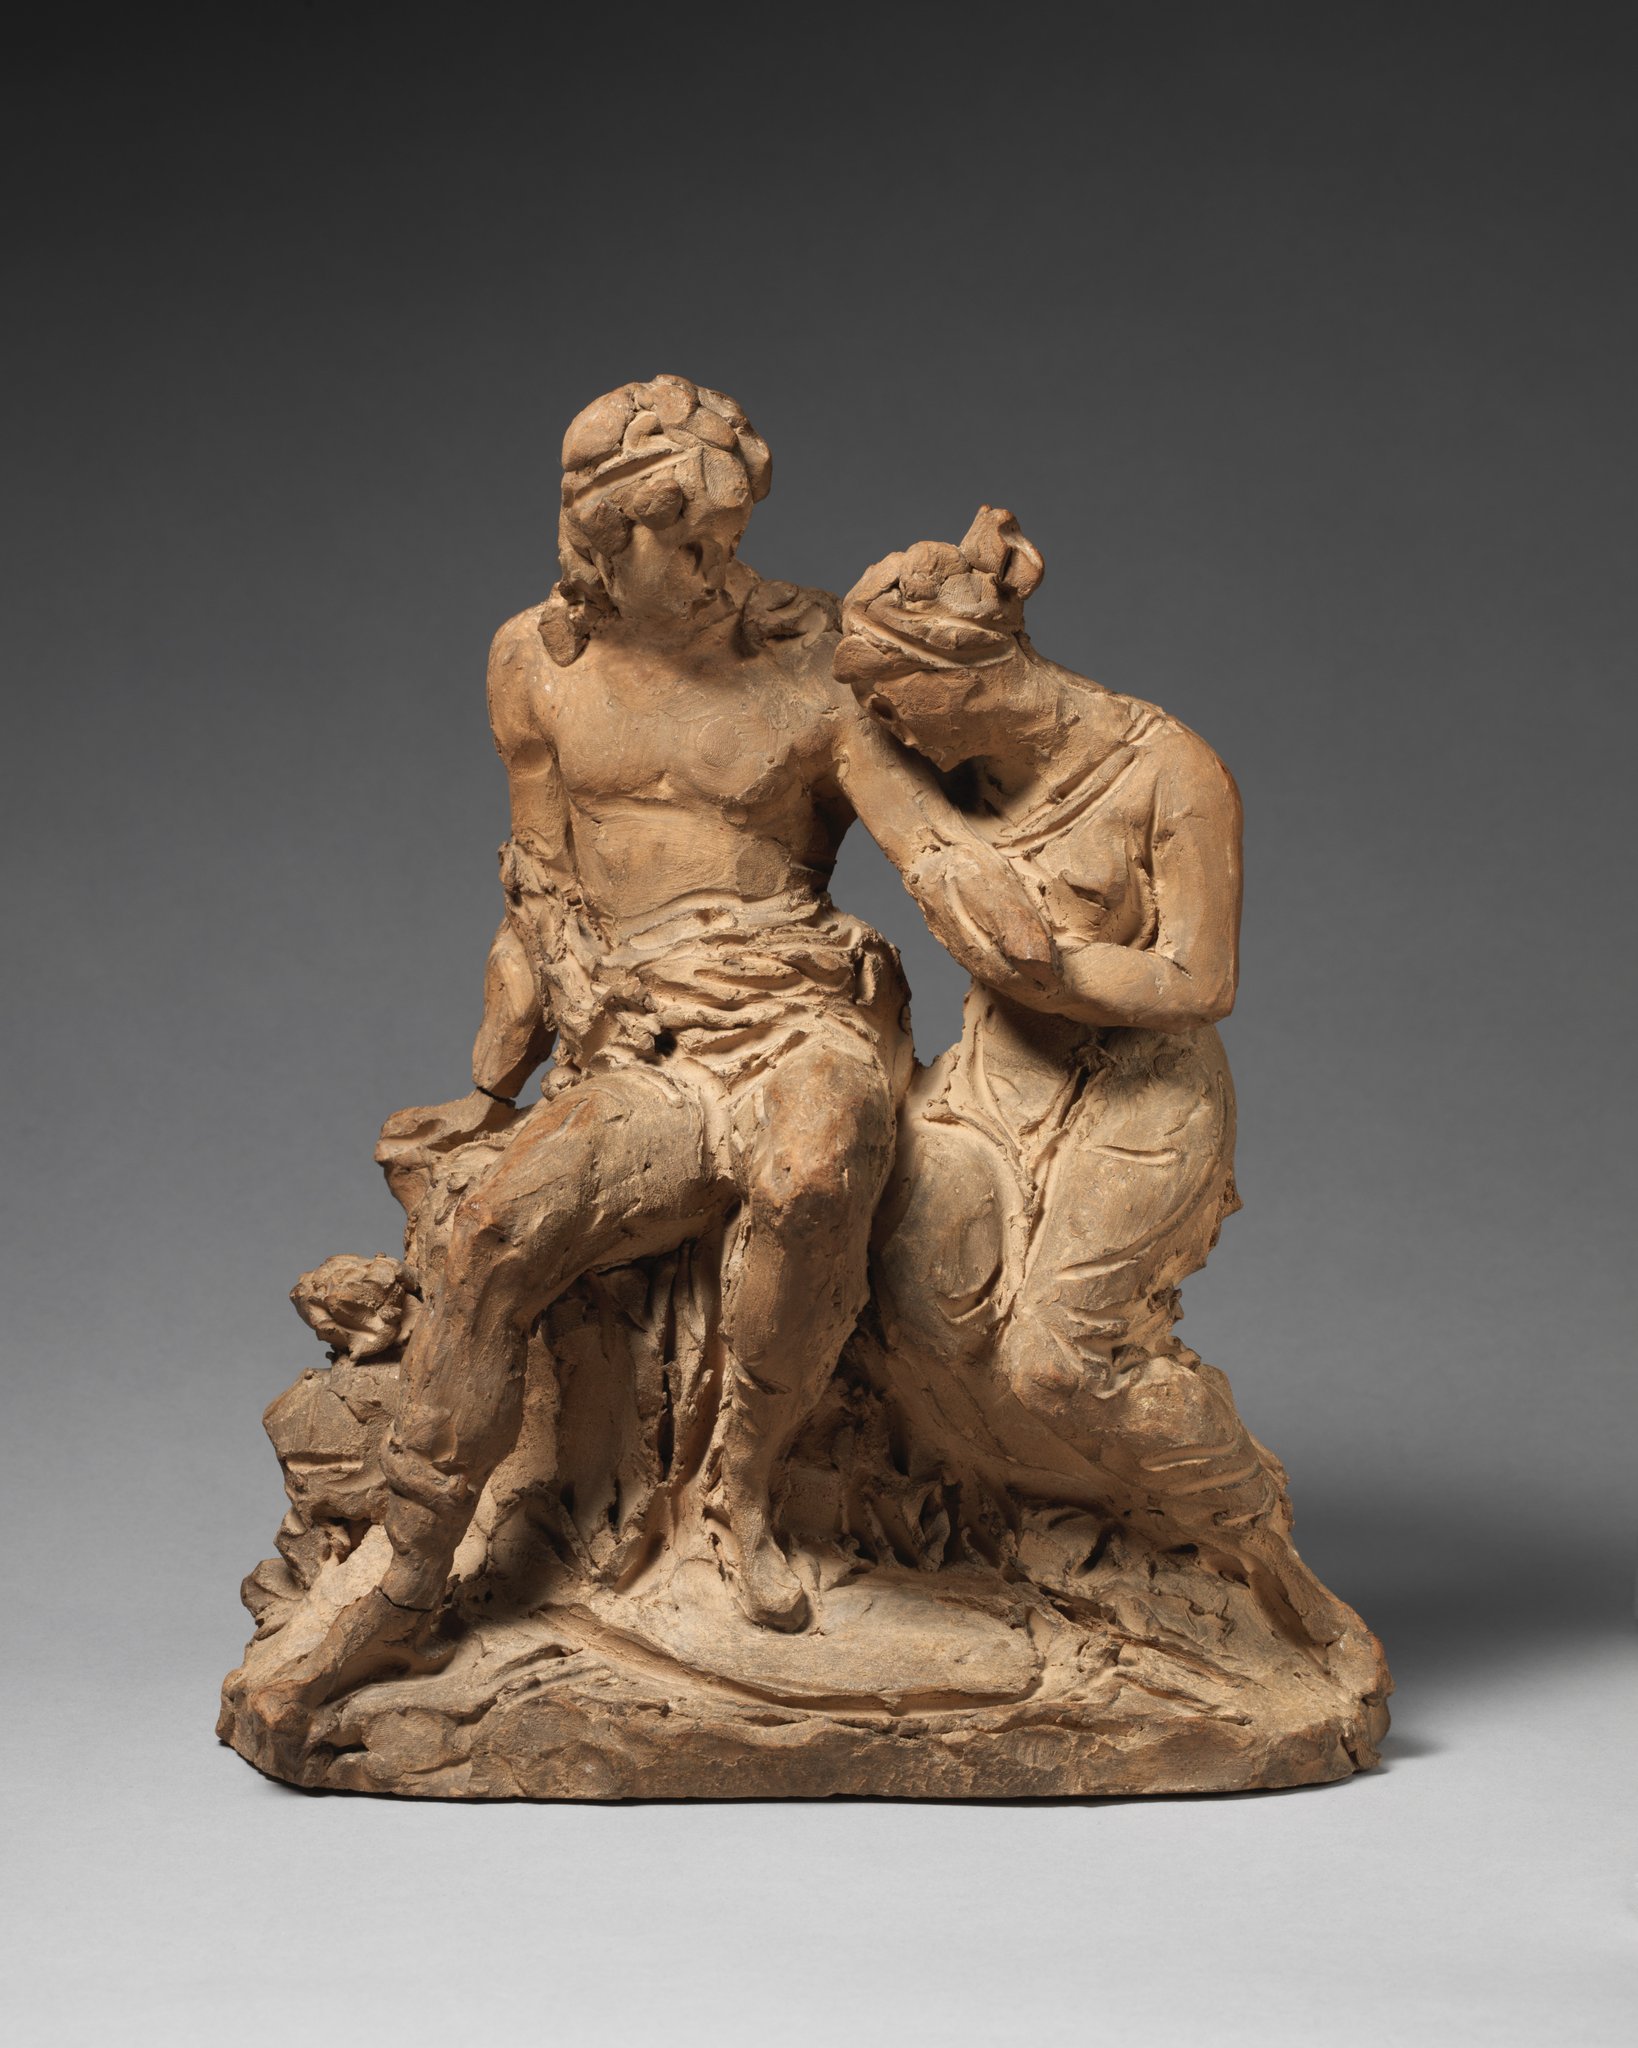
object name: statuette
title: King Edward I (1239–1307) and Queen Eleanor (1241–1290)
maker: charles rossi, r.a.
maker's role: artist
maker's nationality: british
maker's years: 1762-1839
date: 1790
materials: terracotta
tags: kings,queens,men,women